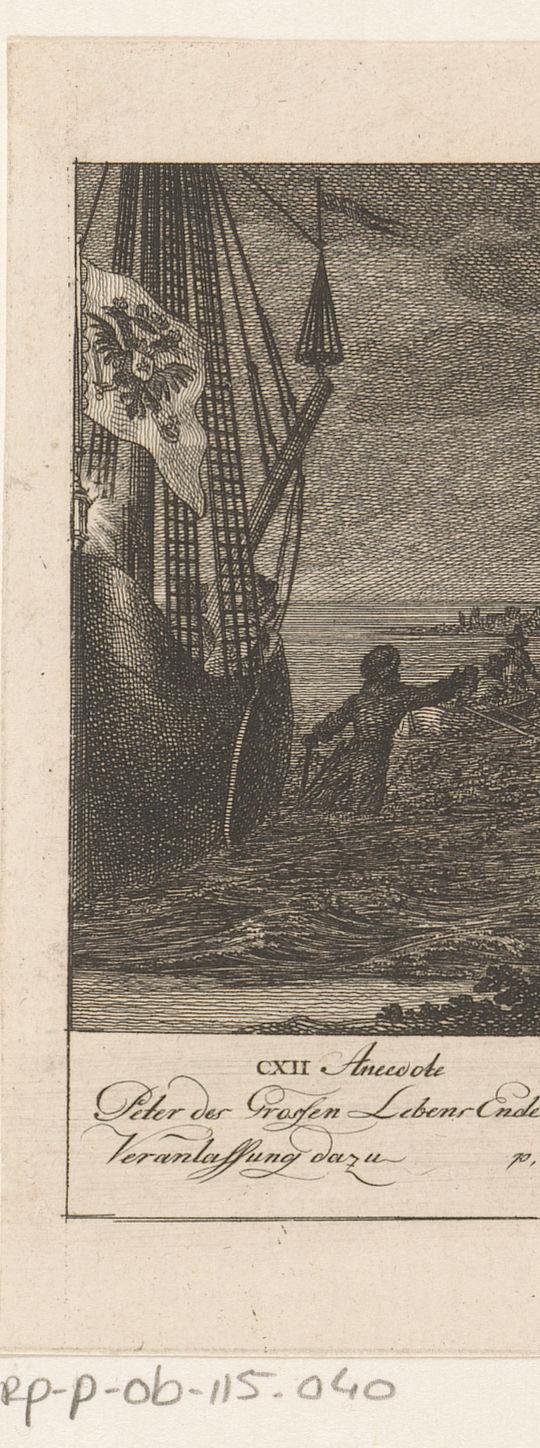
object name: print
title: Peter de Grote ontmoet zijn buitenechtelijke kind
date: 1789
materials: paper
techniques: etching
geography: gottingen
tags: peter i de grote (tsaar van rusland), shaking hands, 'dextrarum junctio', illegitimate child, bastard, history, emperor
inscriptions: collector's mark: Lugt 2228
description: Vervaardigd voor 'Anekdoten vom Peter dem Grossen'. Prent gebruikt voor: Goettinger Taschen Calender vom Jahr 1790. Göttingen: Johann Christoph Dietrich, [1789].